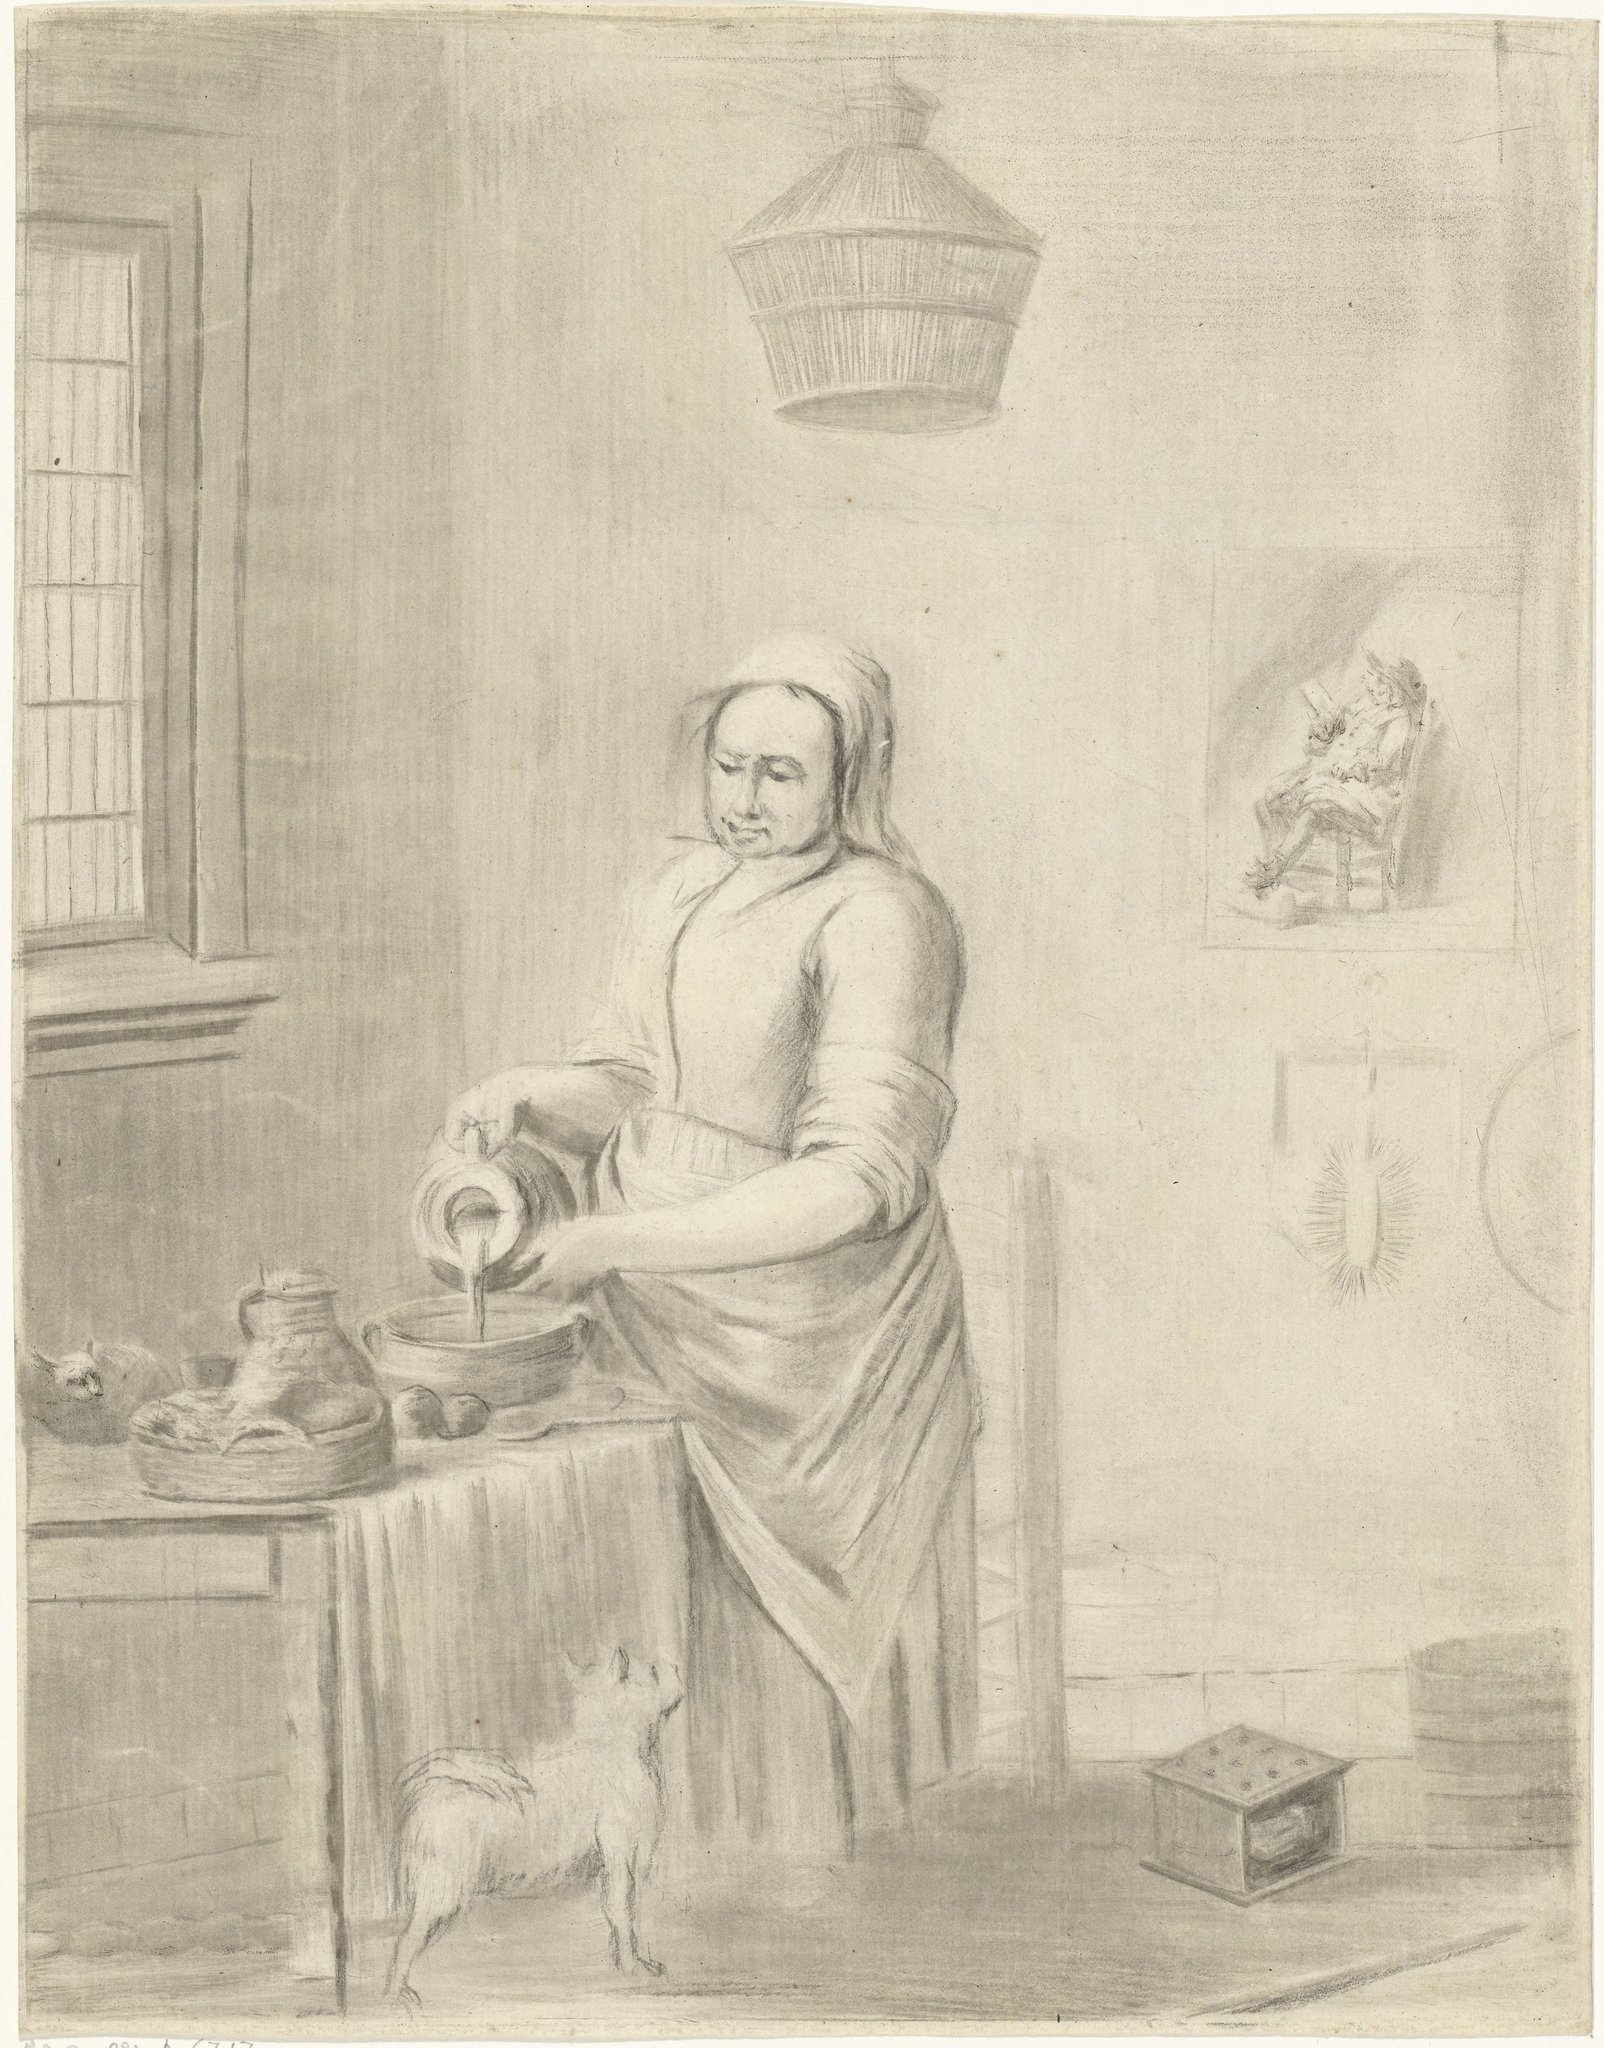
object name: print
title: Het melkmeisje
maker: jurriaan cootwijck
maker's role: print maker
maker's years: 1714-1798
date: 1724-1798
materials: paper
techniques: print drawing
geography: amsterdam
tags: cat, foot-stove, print, e.g.: engraving, etching, lithograph, milk, milkmaid, dog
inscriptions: collector's mark: Lugt 2228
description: Een dienstmaagd staat achter een tafel en schenkt melk uit een kruik in een kom. Op de tafel staat een mand met brood en een stenen kruik. Een kat ligt op de tafel te slapen. Links een venster. Onderaan de muur rechts een stoofje. Op de muur hangt een prent van een man op een stoel. Op de voorgrond een schoothond.